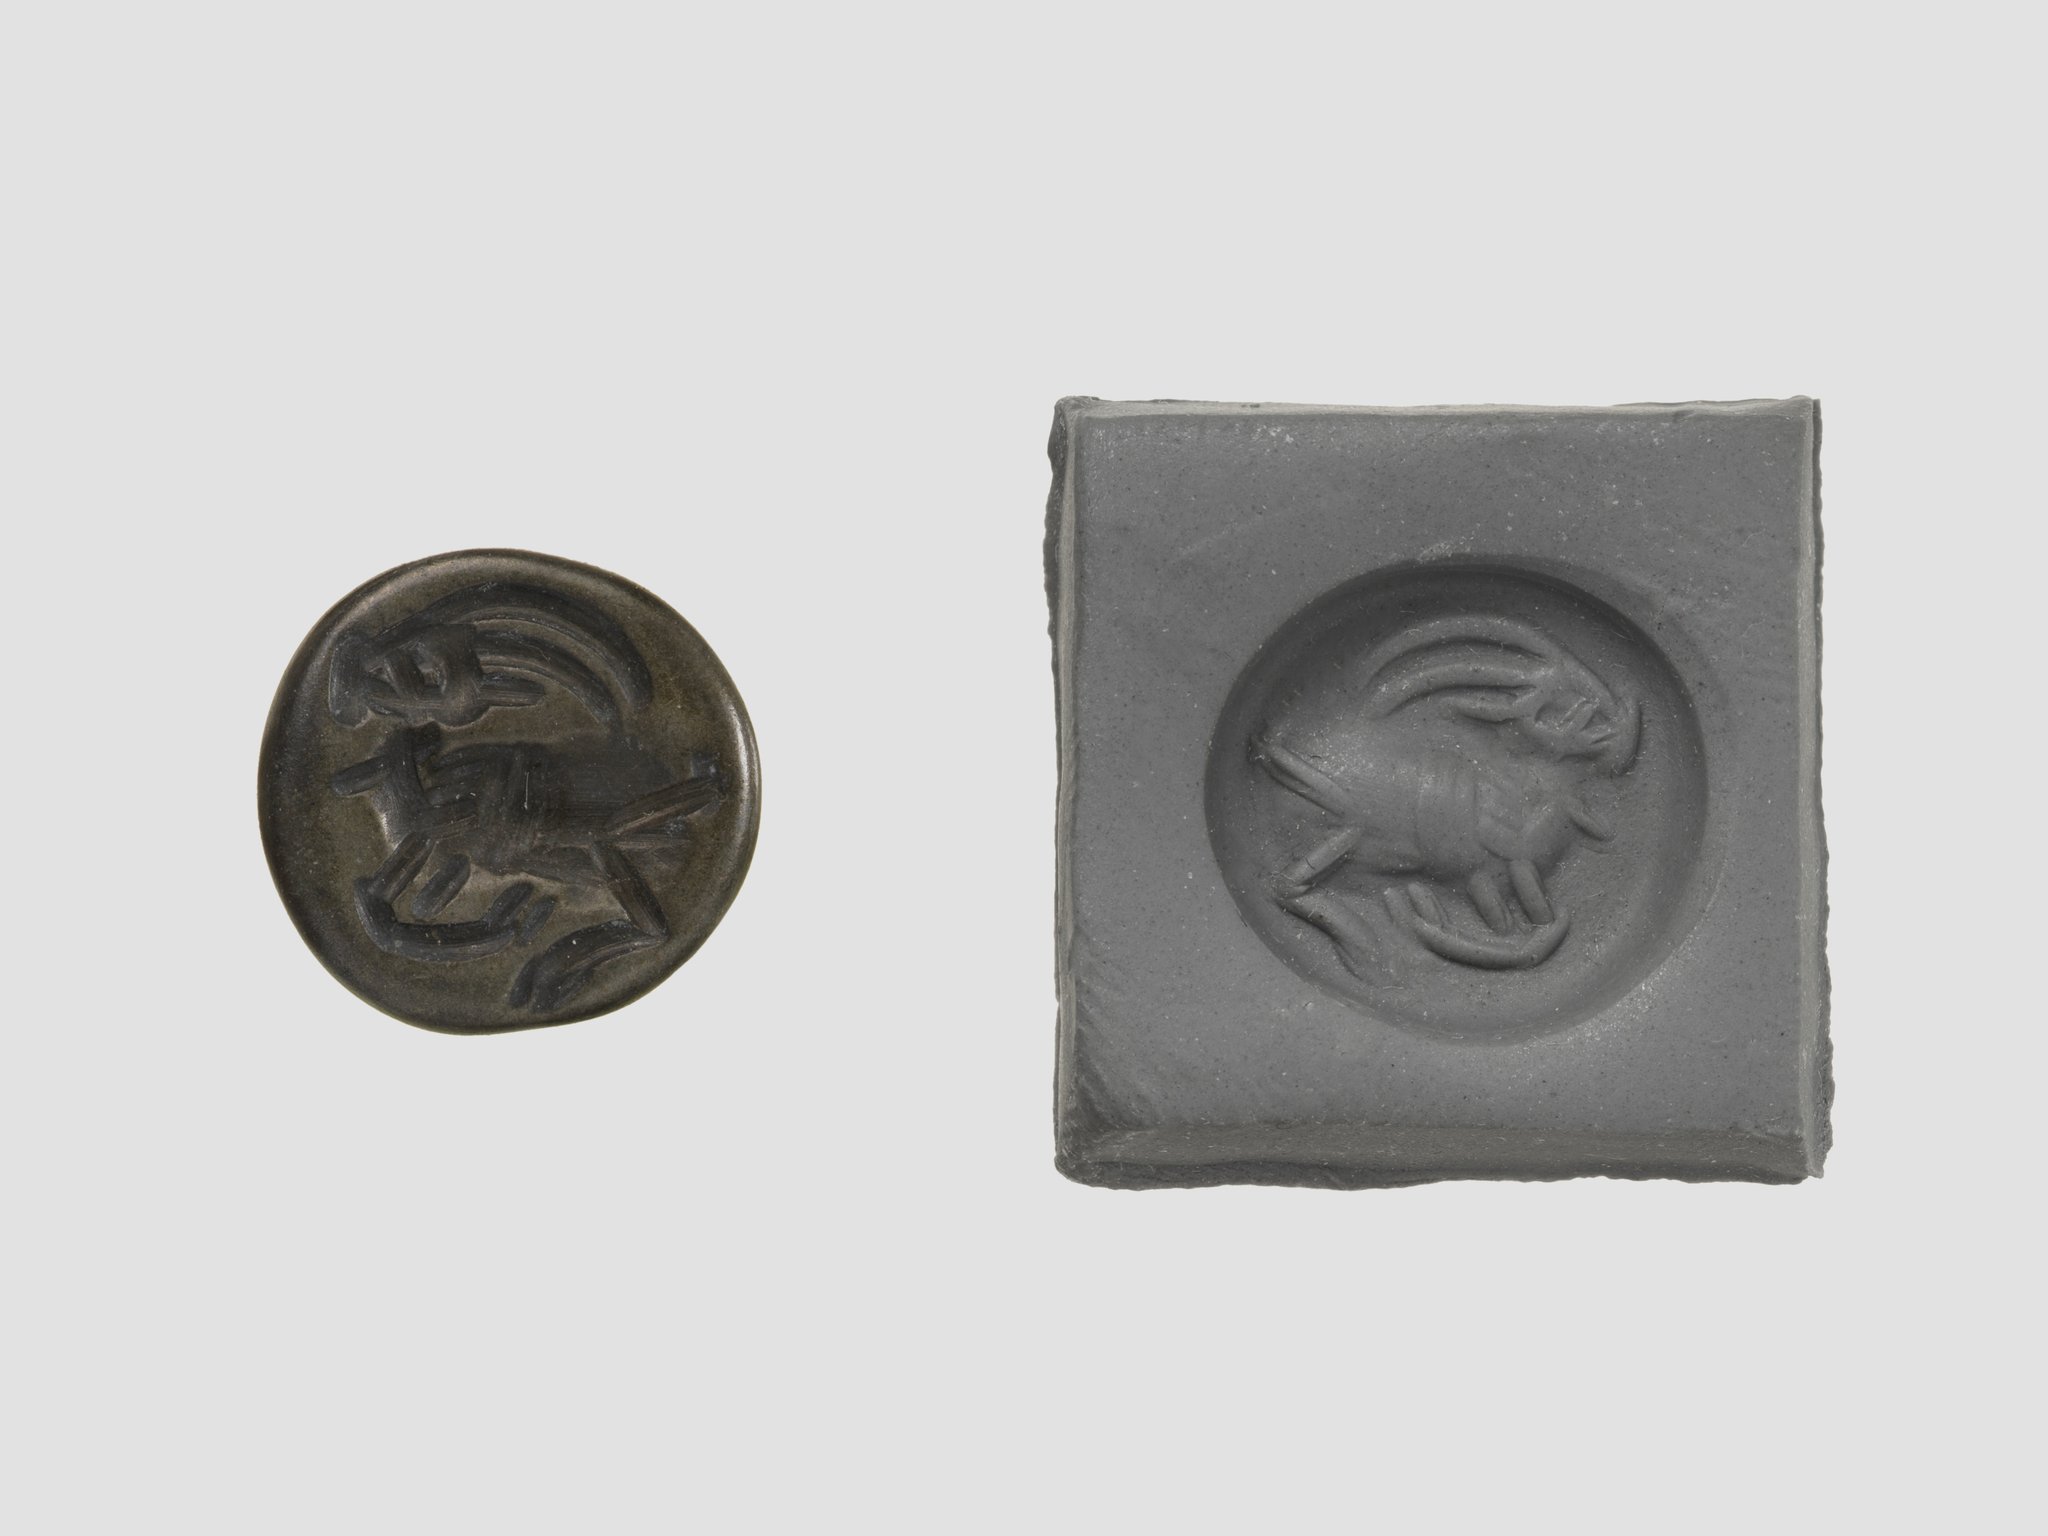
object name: stamp seal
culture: sasanian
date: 201-700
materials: iron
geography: iran or mesopotamia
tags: animals